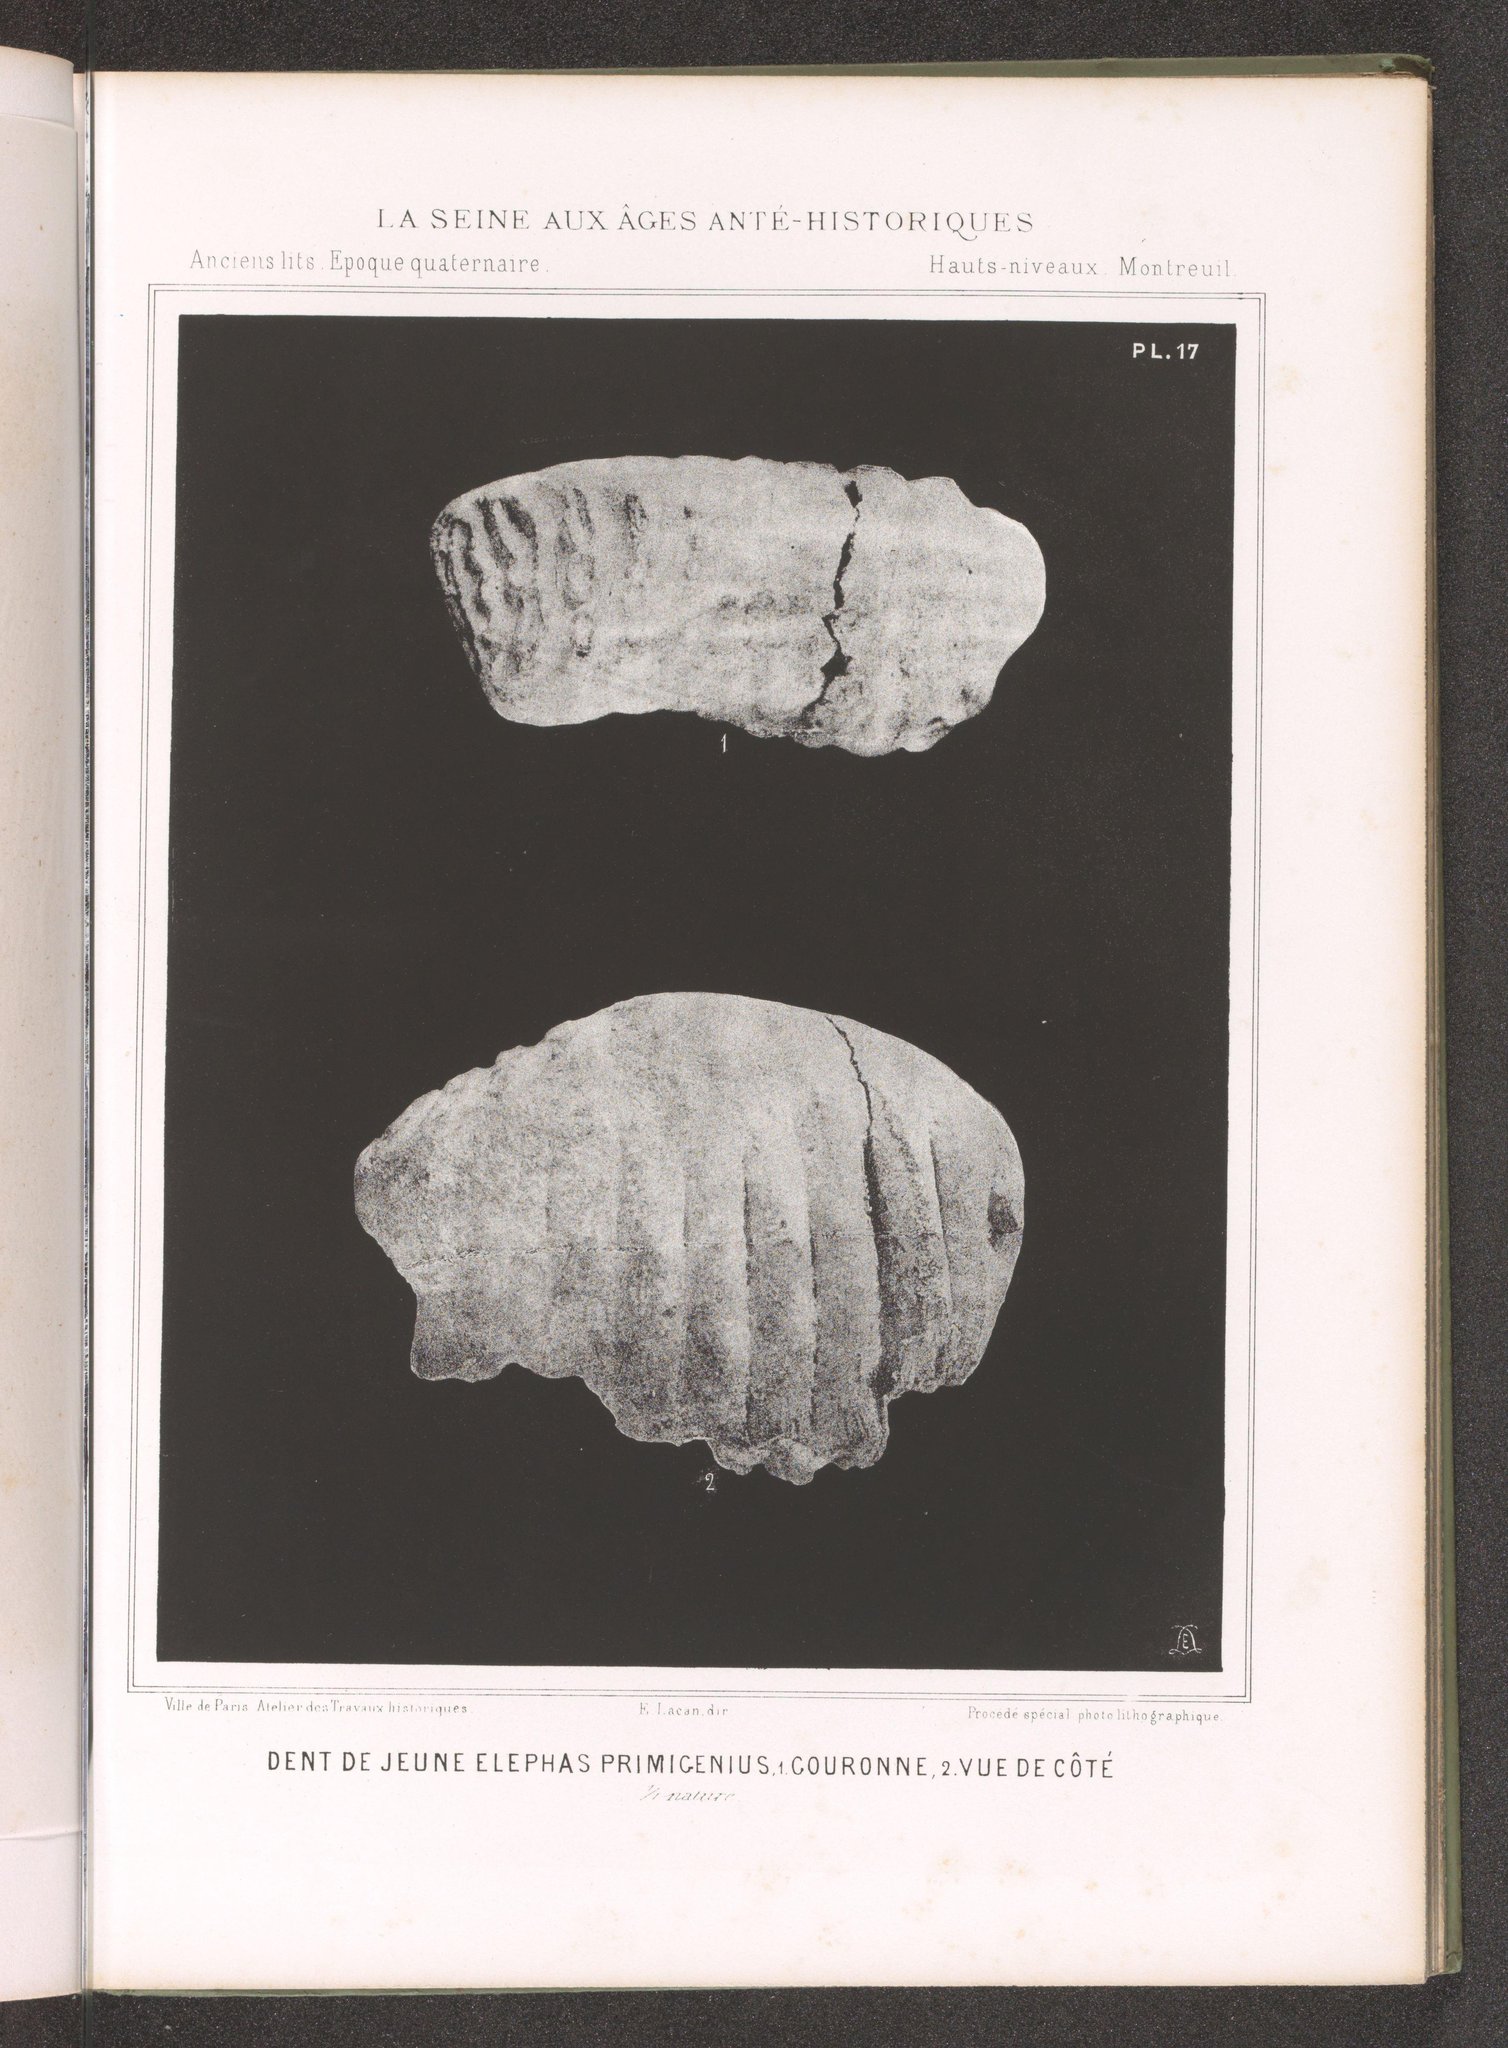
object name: photomechanical print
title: DENT DE JEUNE ELEPHAS PRIMIGENIUS. 1. COURONNE, 2. VUE DE CÔTÉ 1/2 nature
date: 1860-1869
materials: paper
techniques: photolithography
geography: paris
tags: animals (+ skeleton of an animal), palaeontology, france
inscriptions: inscription: ‘Ville de Paris. Atelier des Travaux historiques E. Lacan, dir. Procédé spécial photo-lithographique.’, number: ‘Pl. 17’, monogram: ‘LEL’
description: Voor plek prent in boek: zie nummer onder 'Opschriften / Merken'.